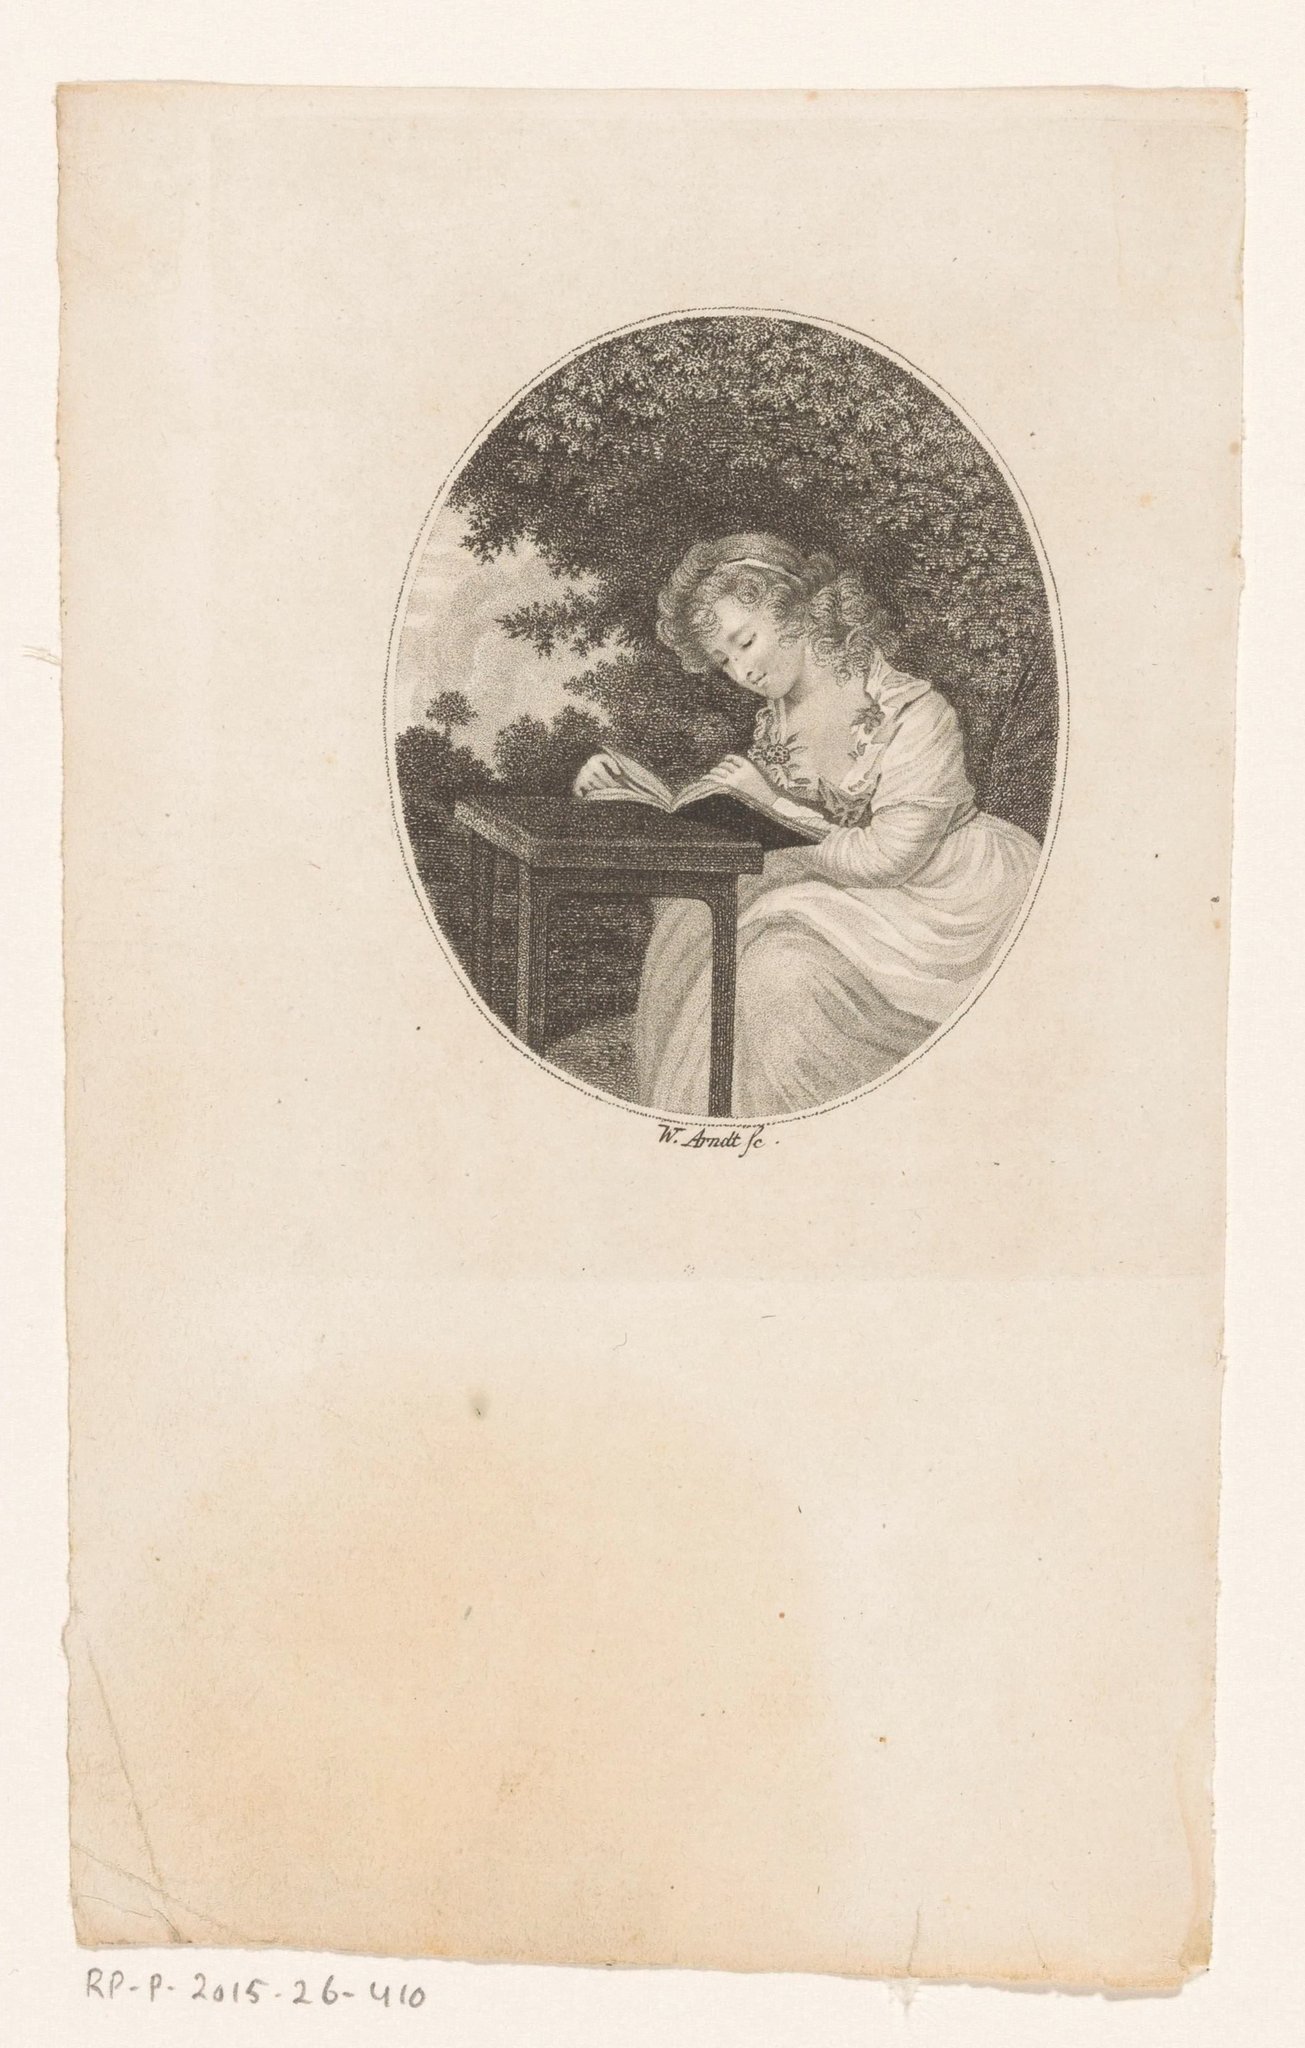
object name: print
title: Lezende jonge vrouw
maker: wilhelm arndt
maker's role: print maker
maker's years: 1750-1813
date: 1799-1813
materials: paper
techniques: stippled etching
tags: reading, book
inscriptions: collector's mark: Lugt 2228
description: In een ovaal. Buiten achter een tafel gezeten, gebladerte in de achtergrond.